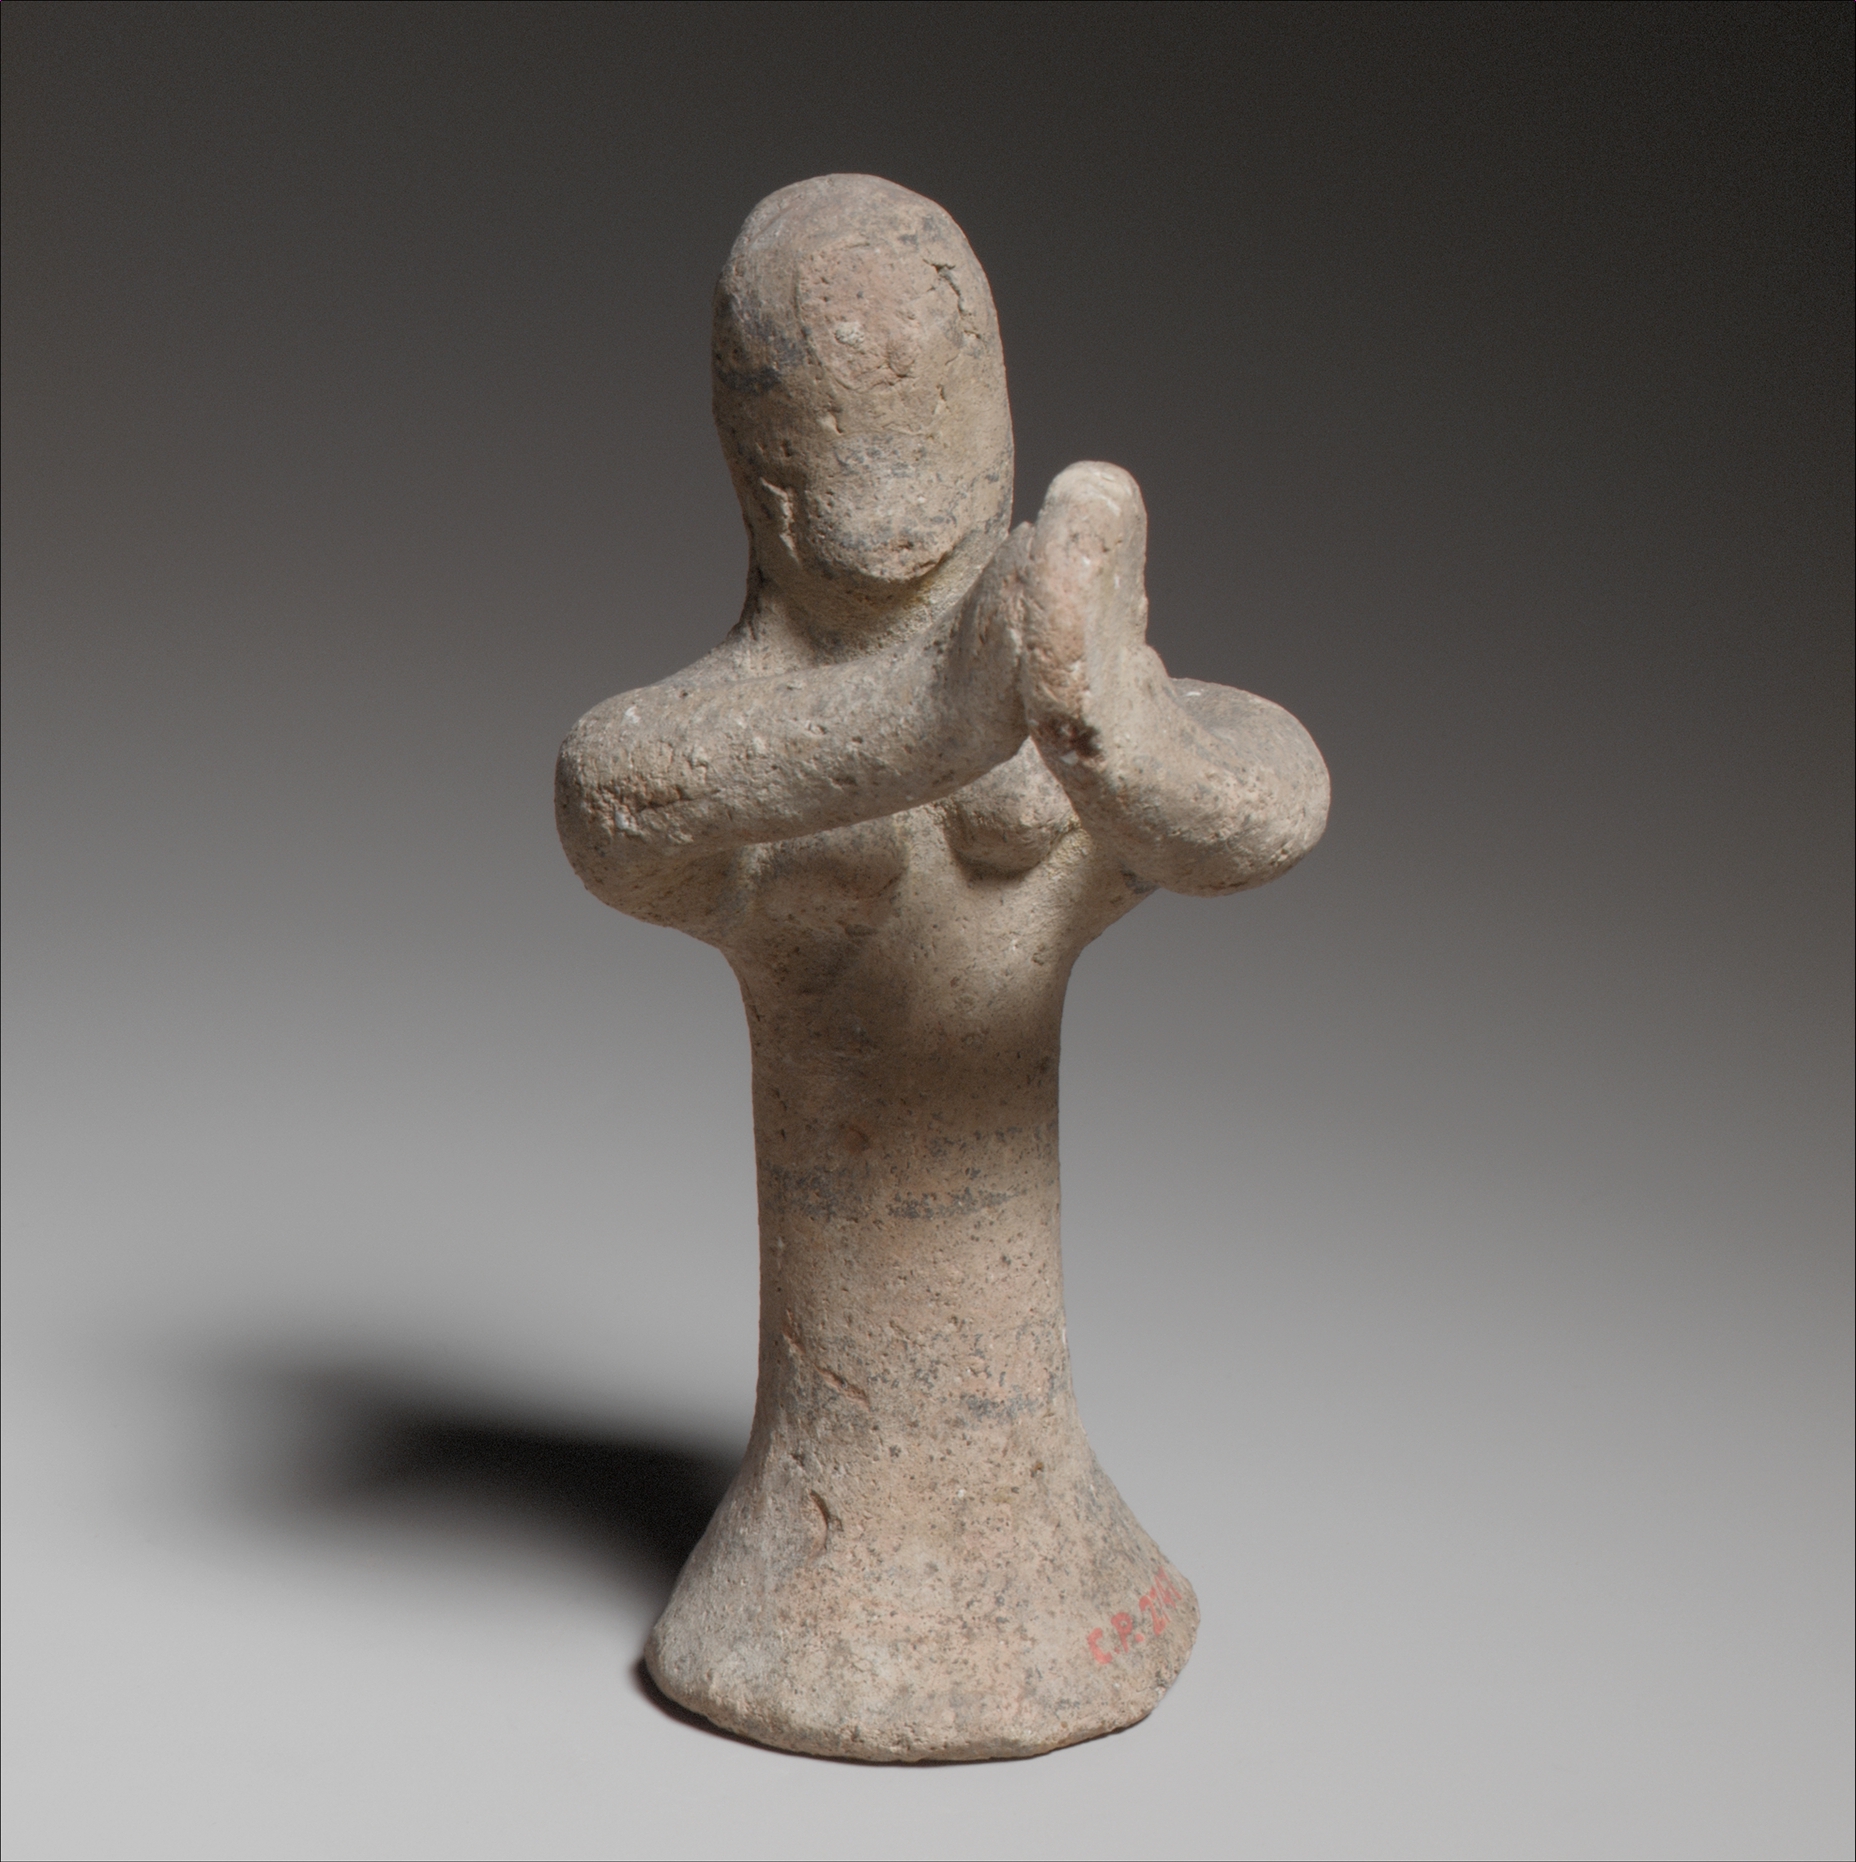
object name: statuette of a votary, female, playing tambourine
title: Standing female tambourine player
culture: cypriot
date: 600-480 BCE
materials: terracotta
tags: women,musicians